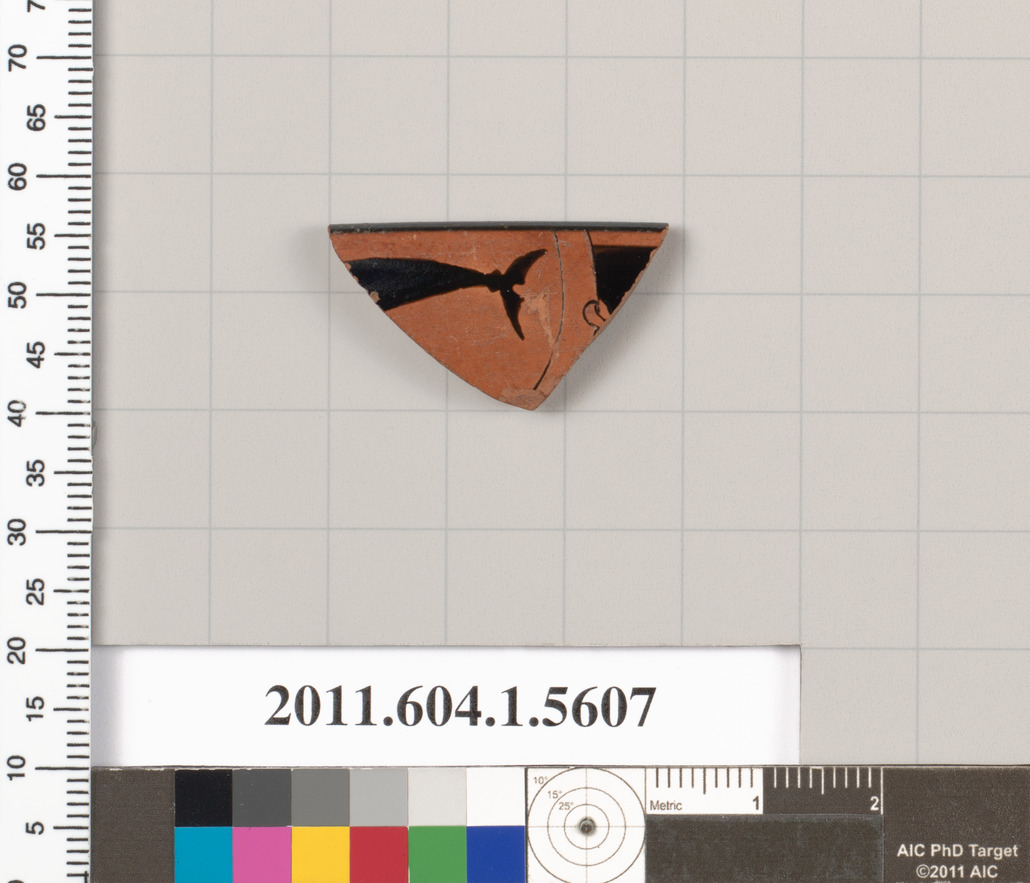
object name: kylix fragment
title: Terracotta rim fragment of a kylix (drinking cup)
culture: greek, attic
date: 510-490 BCE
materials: terracotta